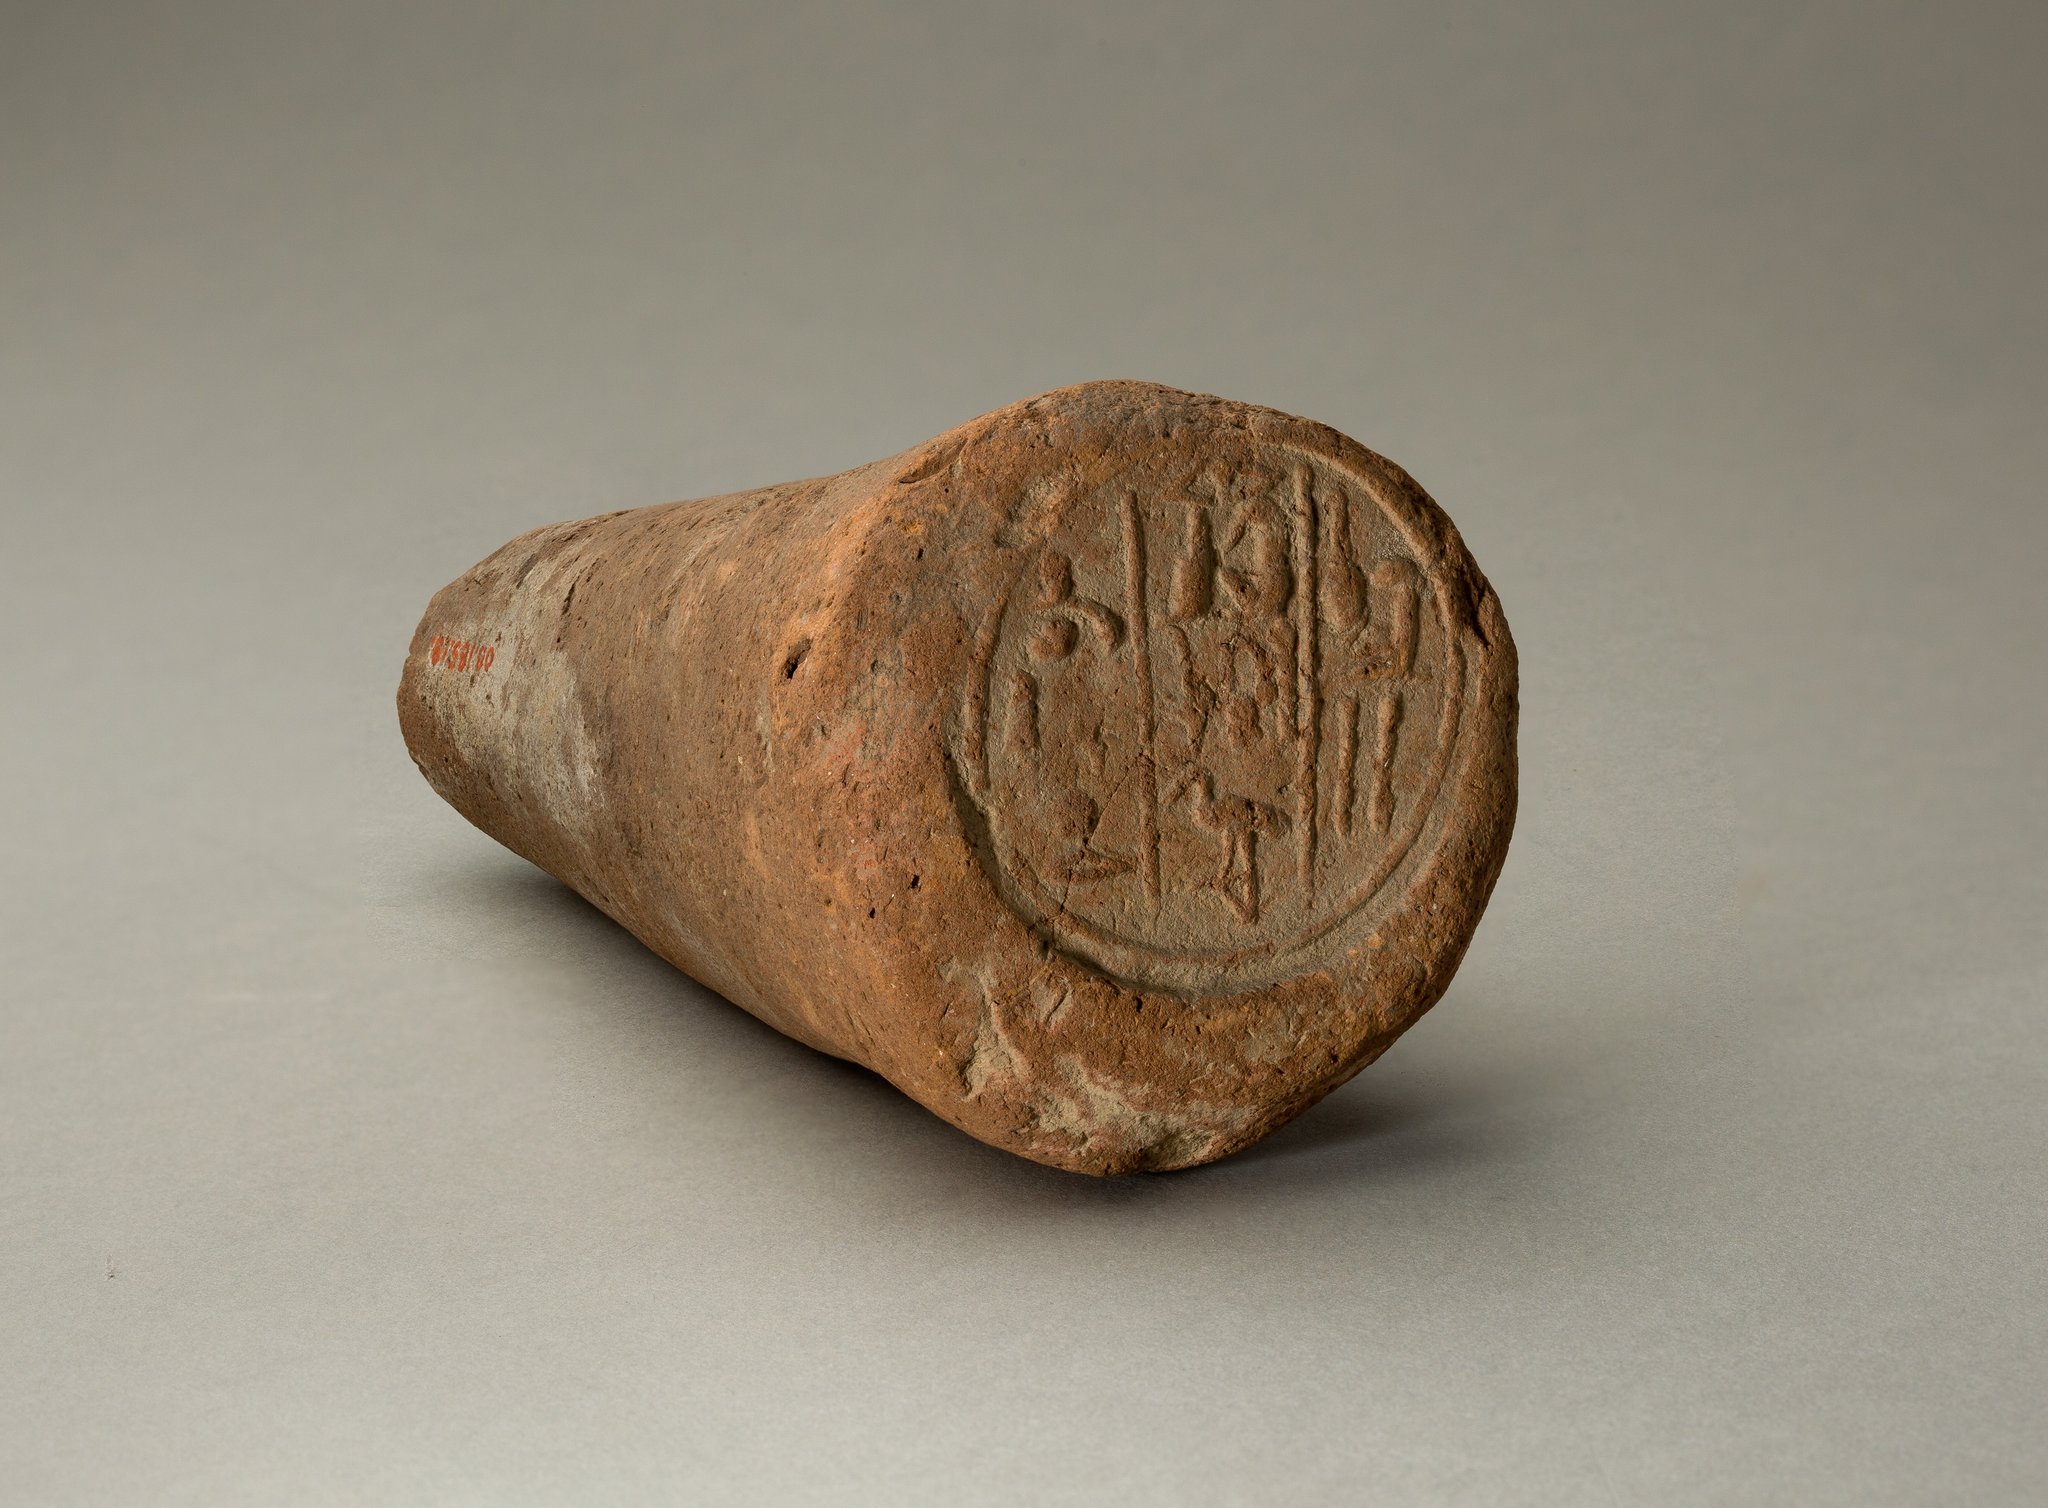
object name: cone, circular impression, djehutynefer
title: Funerary Cone of Djehutynefer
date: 1550-1352 BCE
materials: pottery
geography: egypt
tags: hieroglyphs